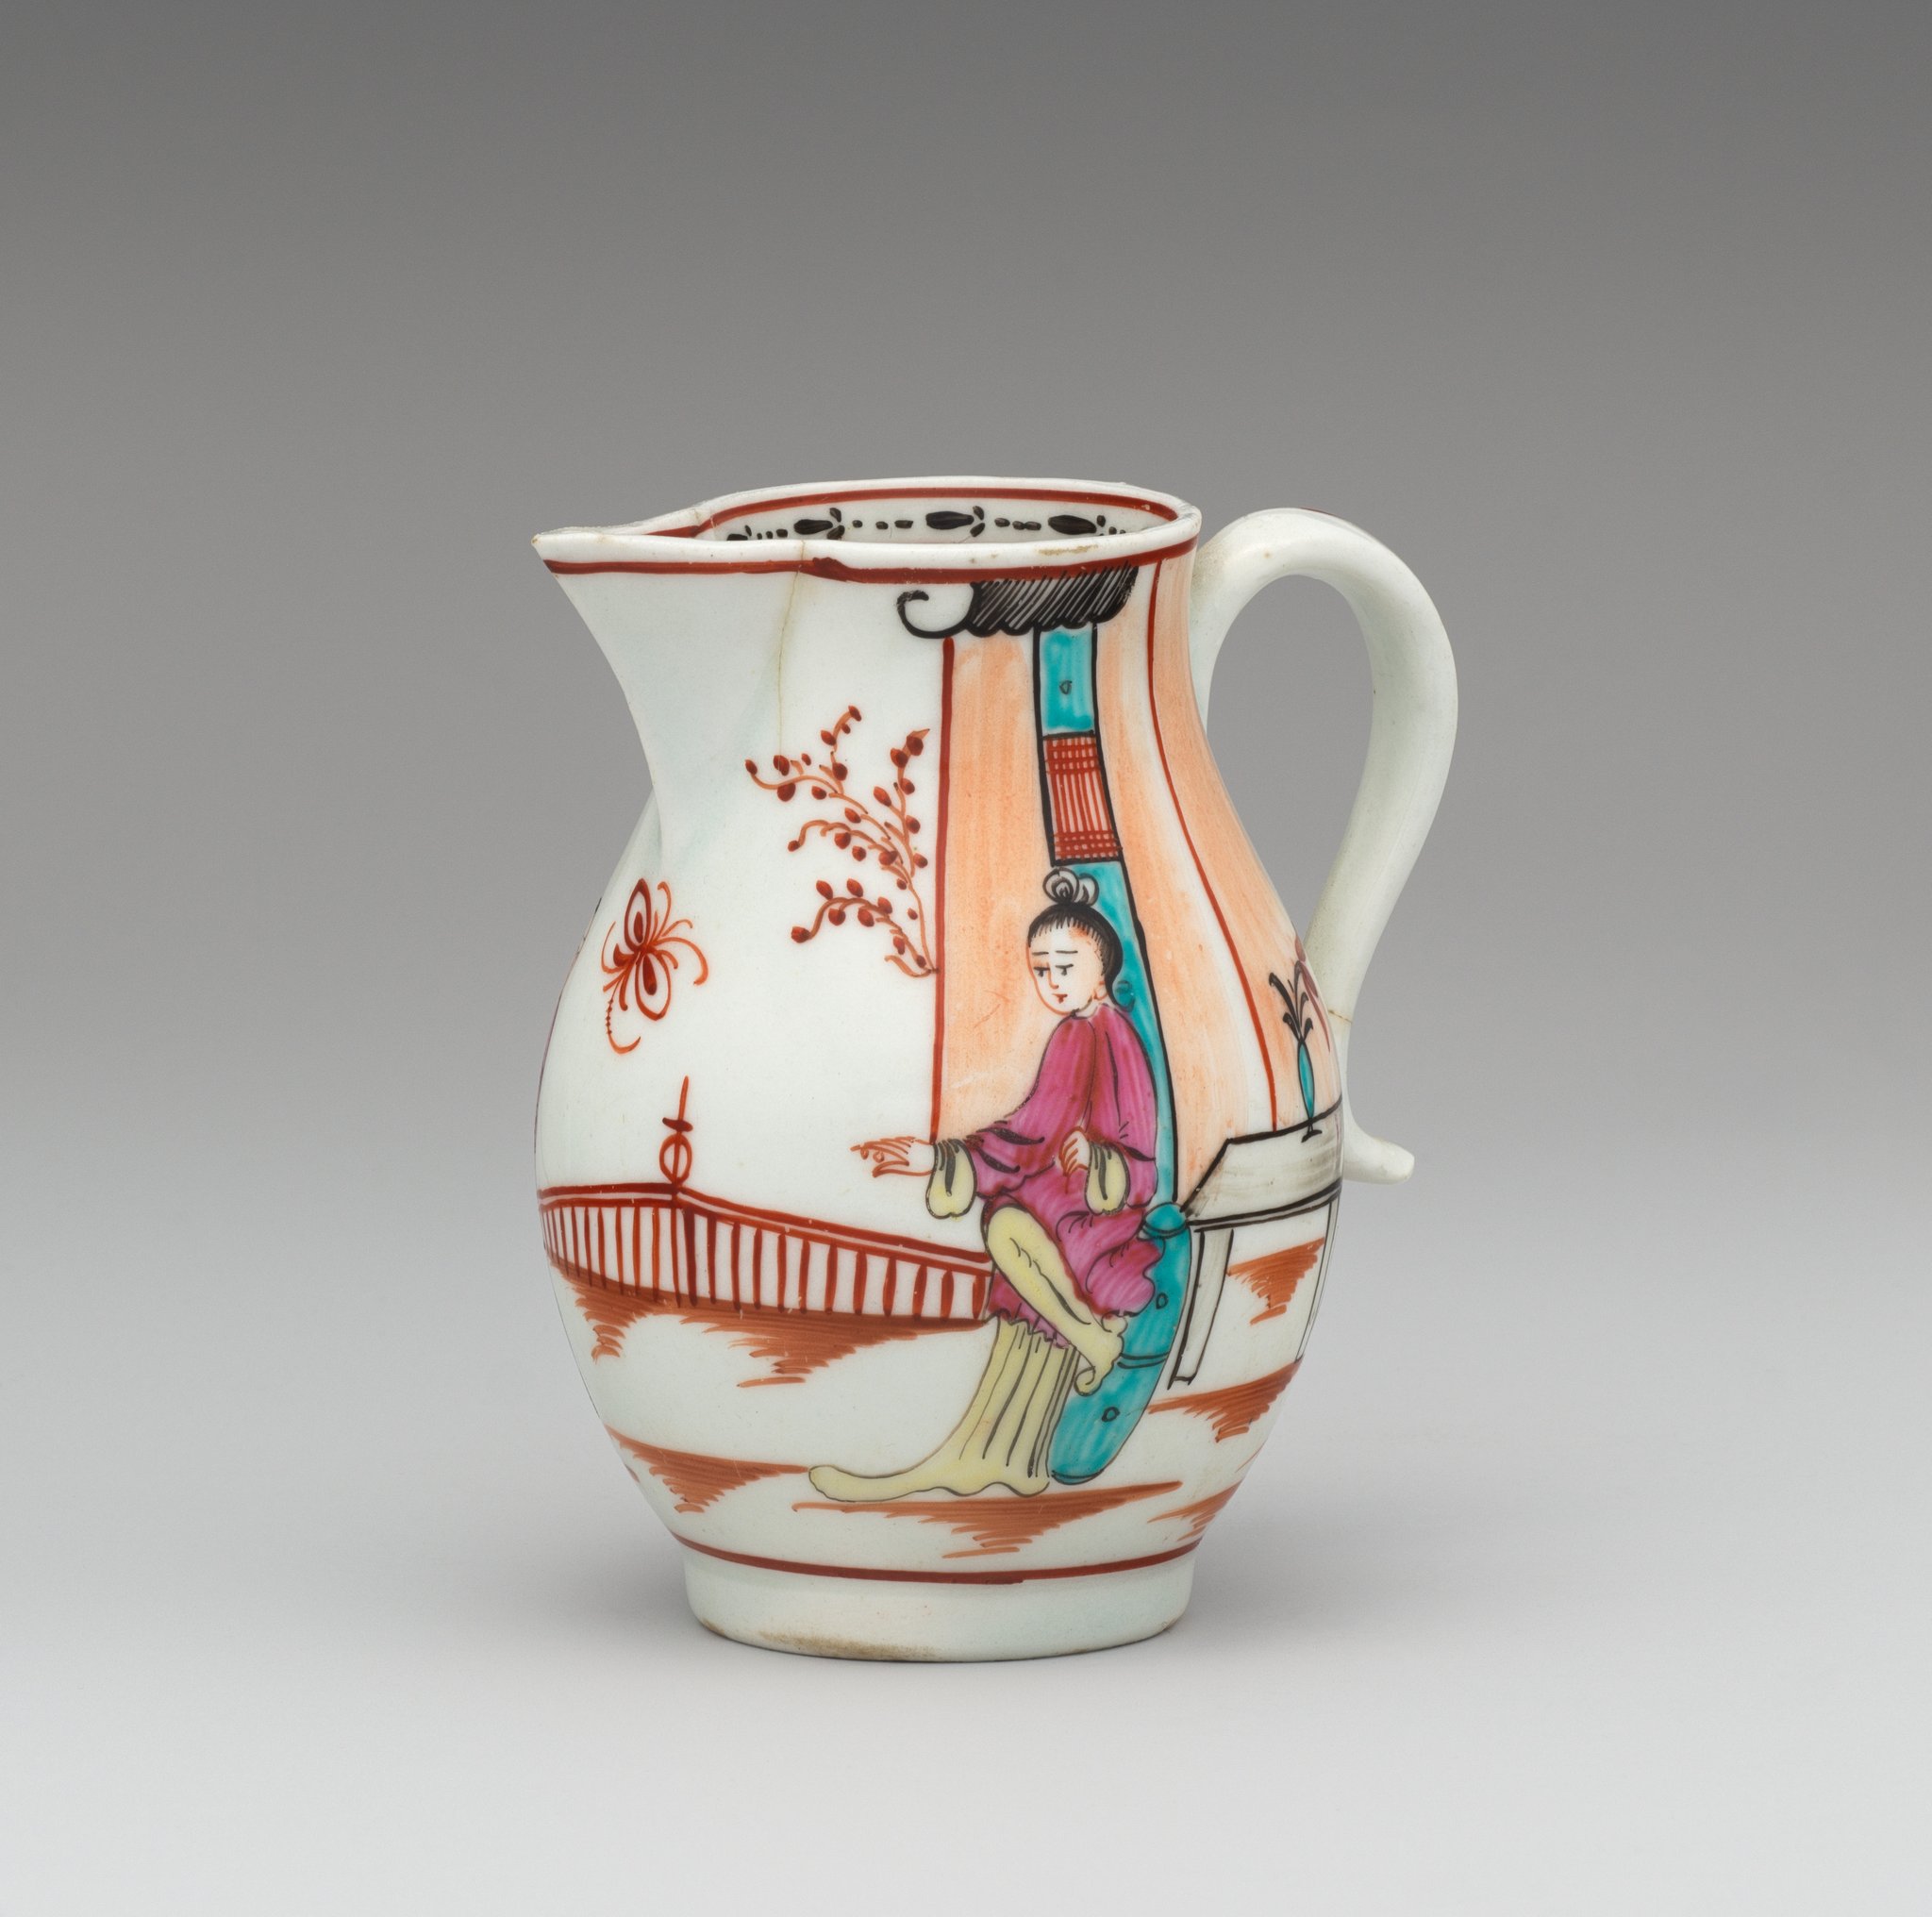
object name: cream pitcher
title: Cream pitcher (part of a service)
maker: lowestoft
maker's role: factory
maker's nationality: british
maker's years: 1757-1803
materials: soft paste porcelain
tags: women